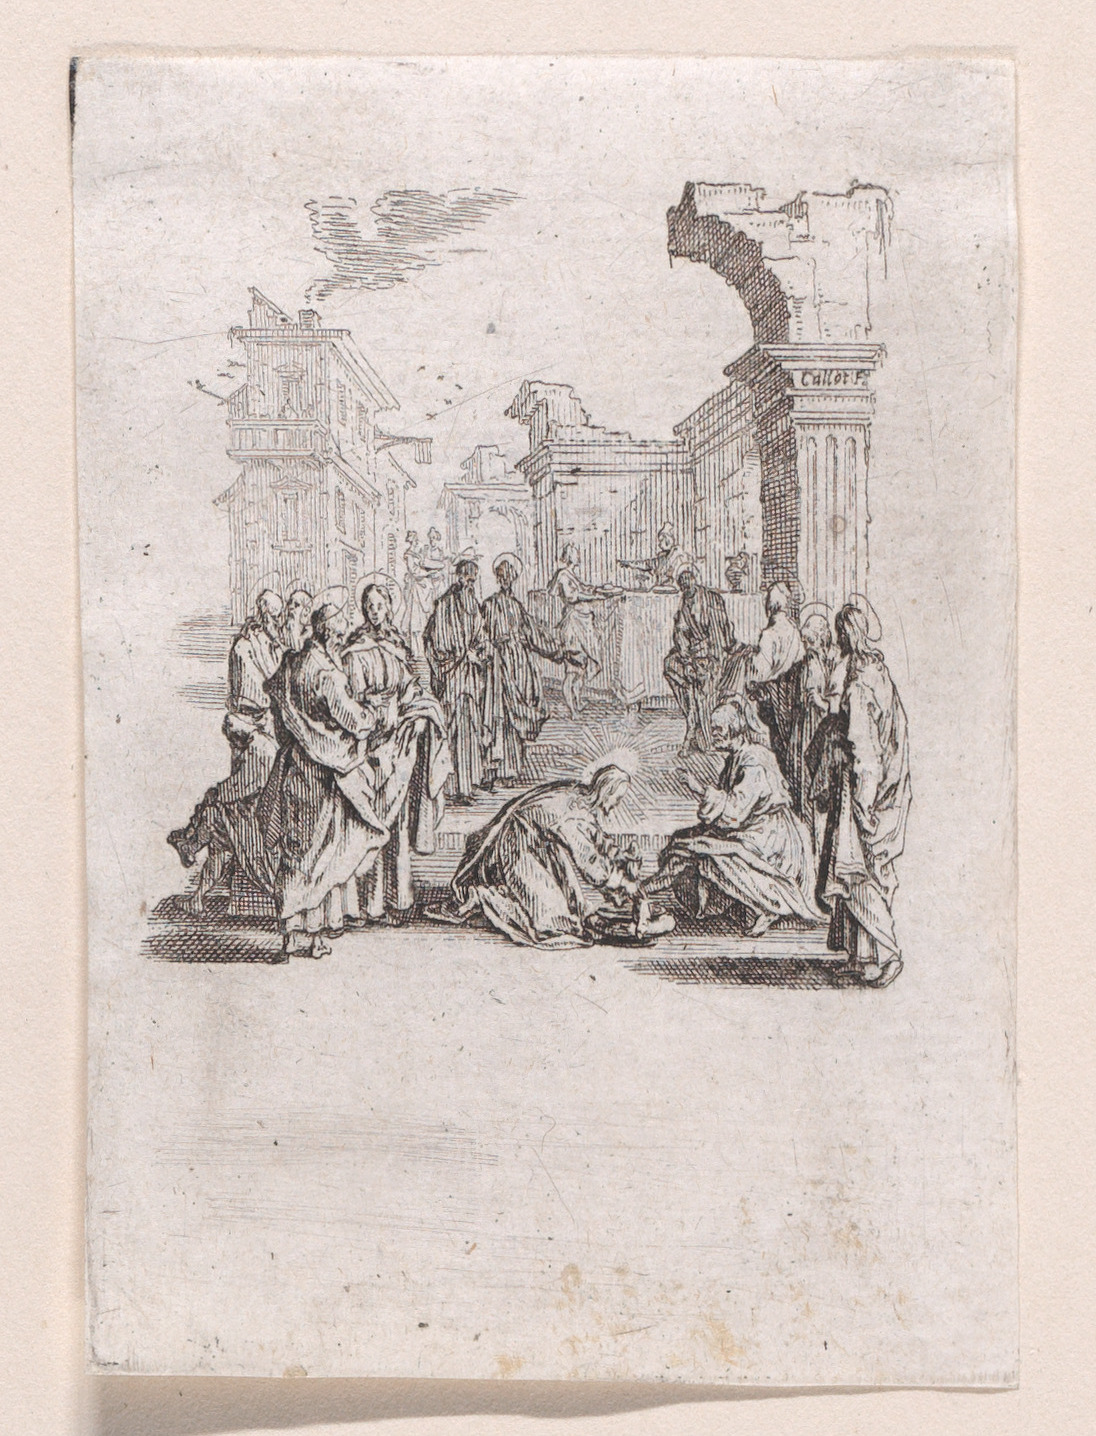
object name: print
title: Le Lavement des Pieds (The Washing of the Feet), from "La Petite Passion" (The Little Passion)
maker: jacques callot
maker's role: artist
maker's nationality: french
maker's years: 1592-1635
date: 1624-1625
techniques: etching